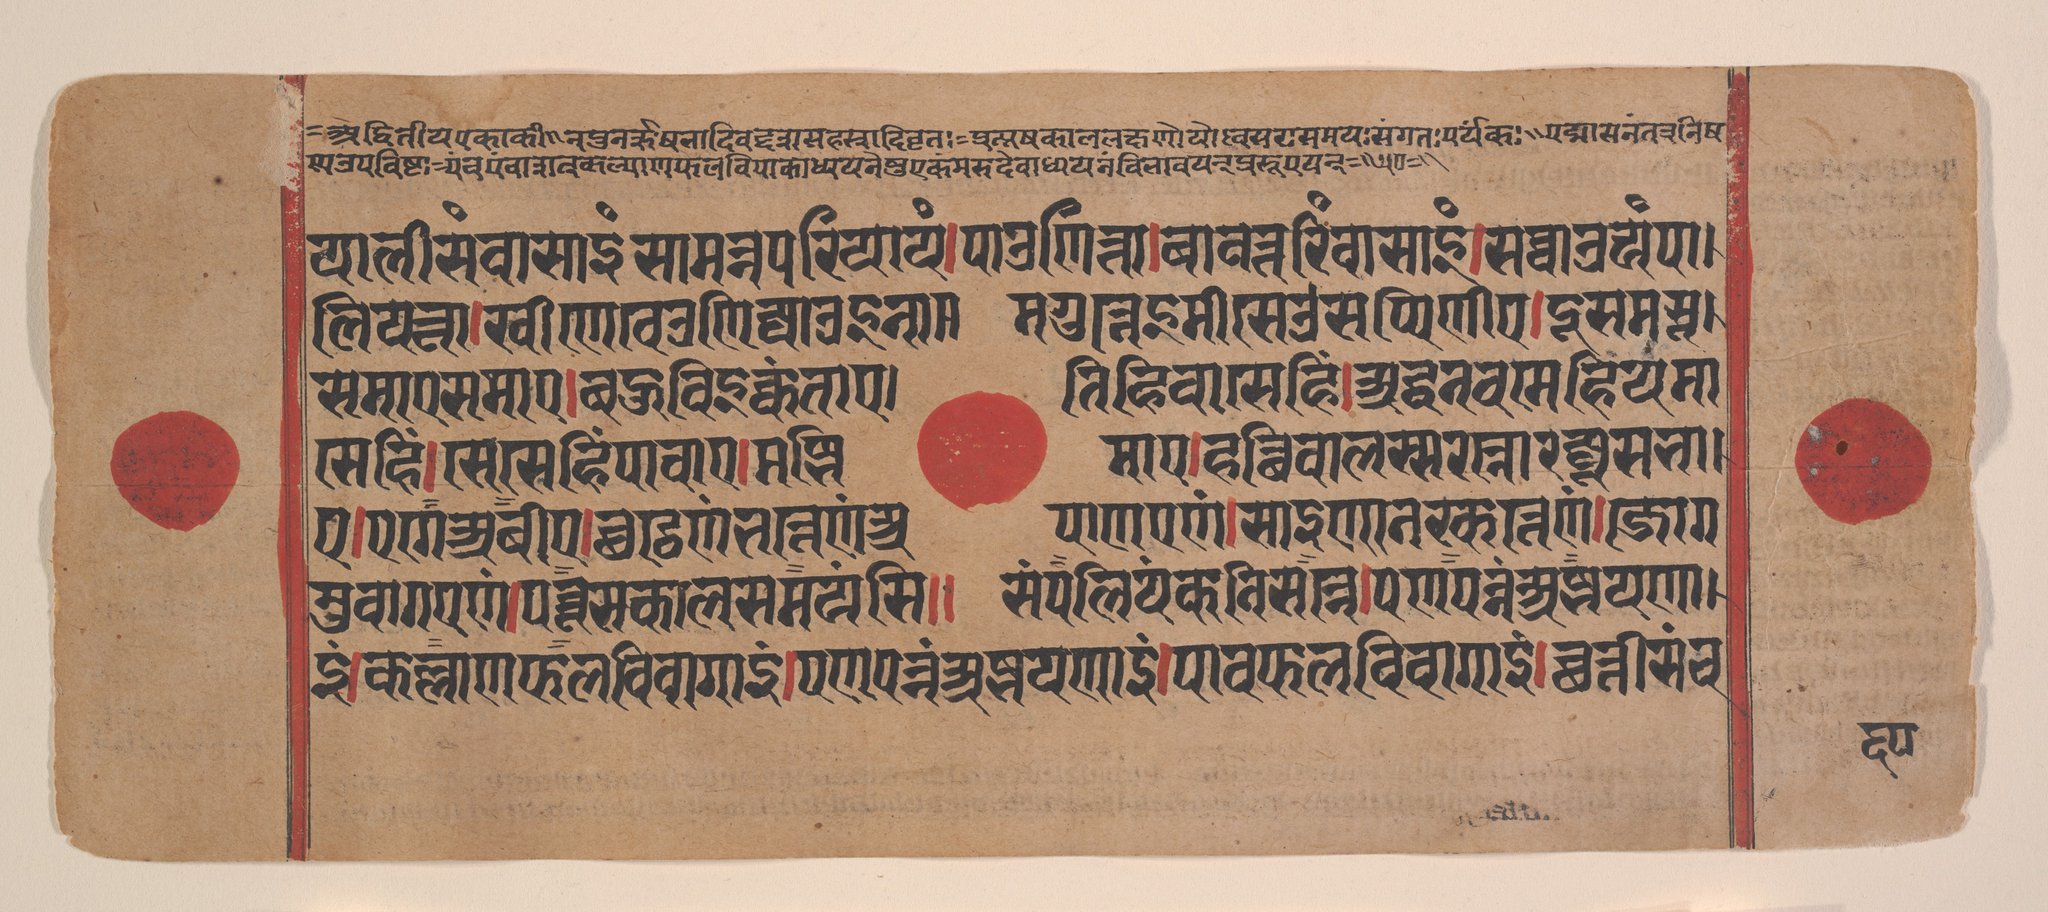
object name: folio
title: Page from a Dispersed Kalpa Sutra (Jain Book of Rituals)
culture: indian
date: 1401-1500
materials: gold, ink, paper, watercolor